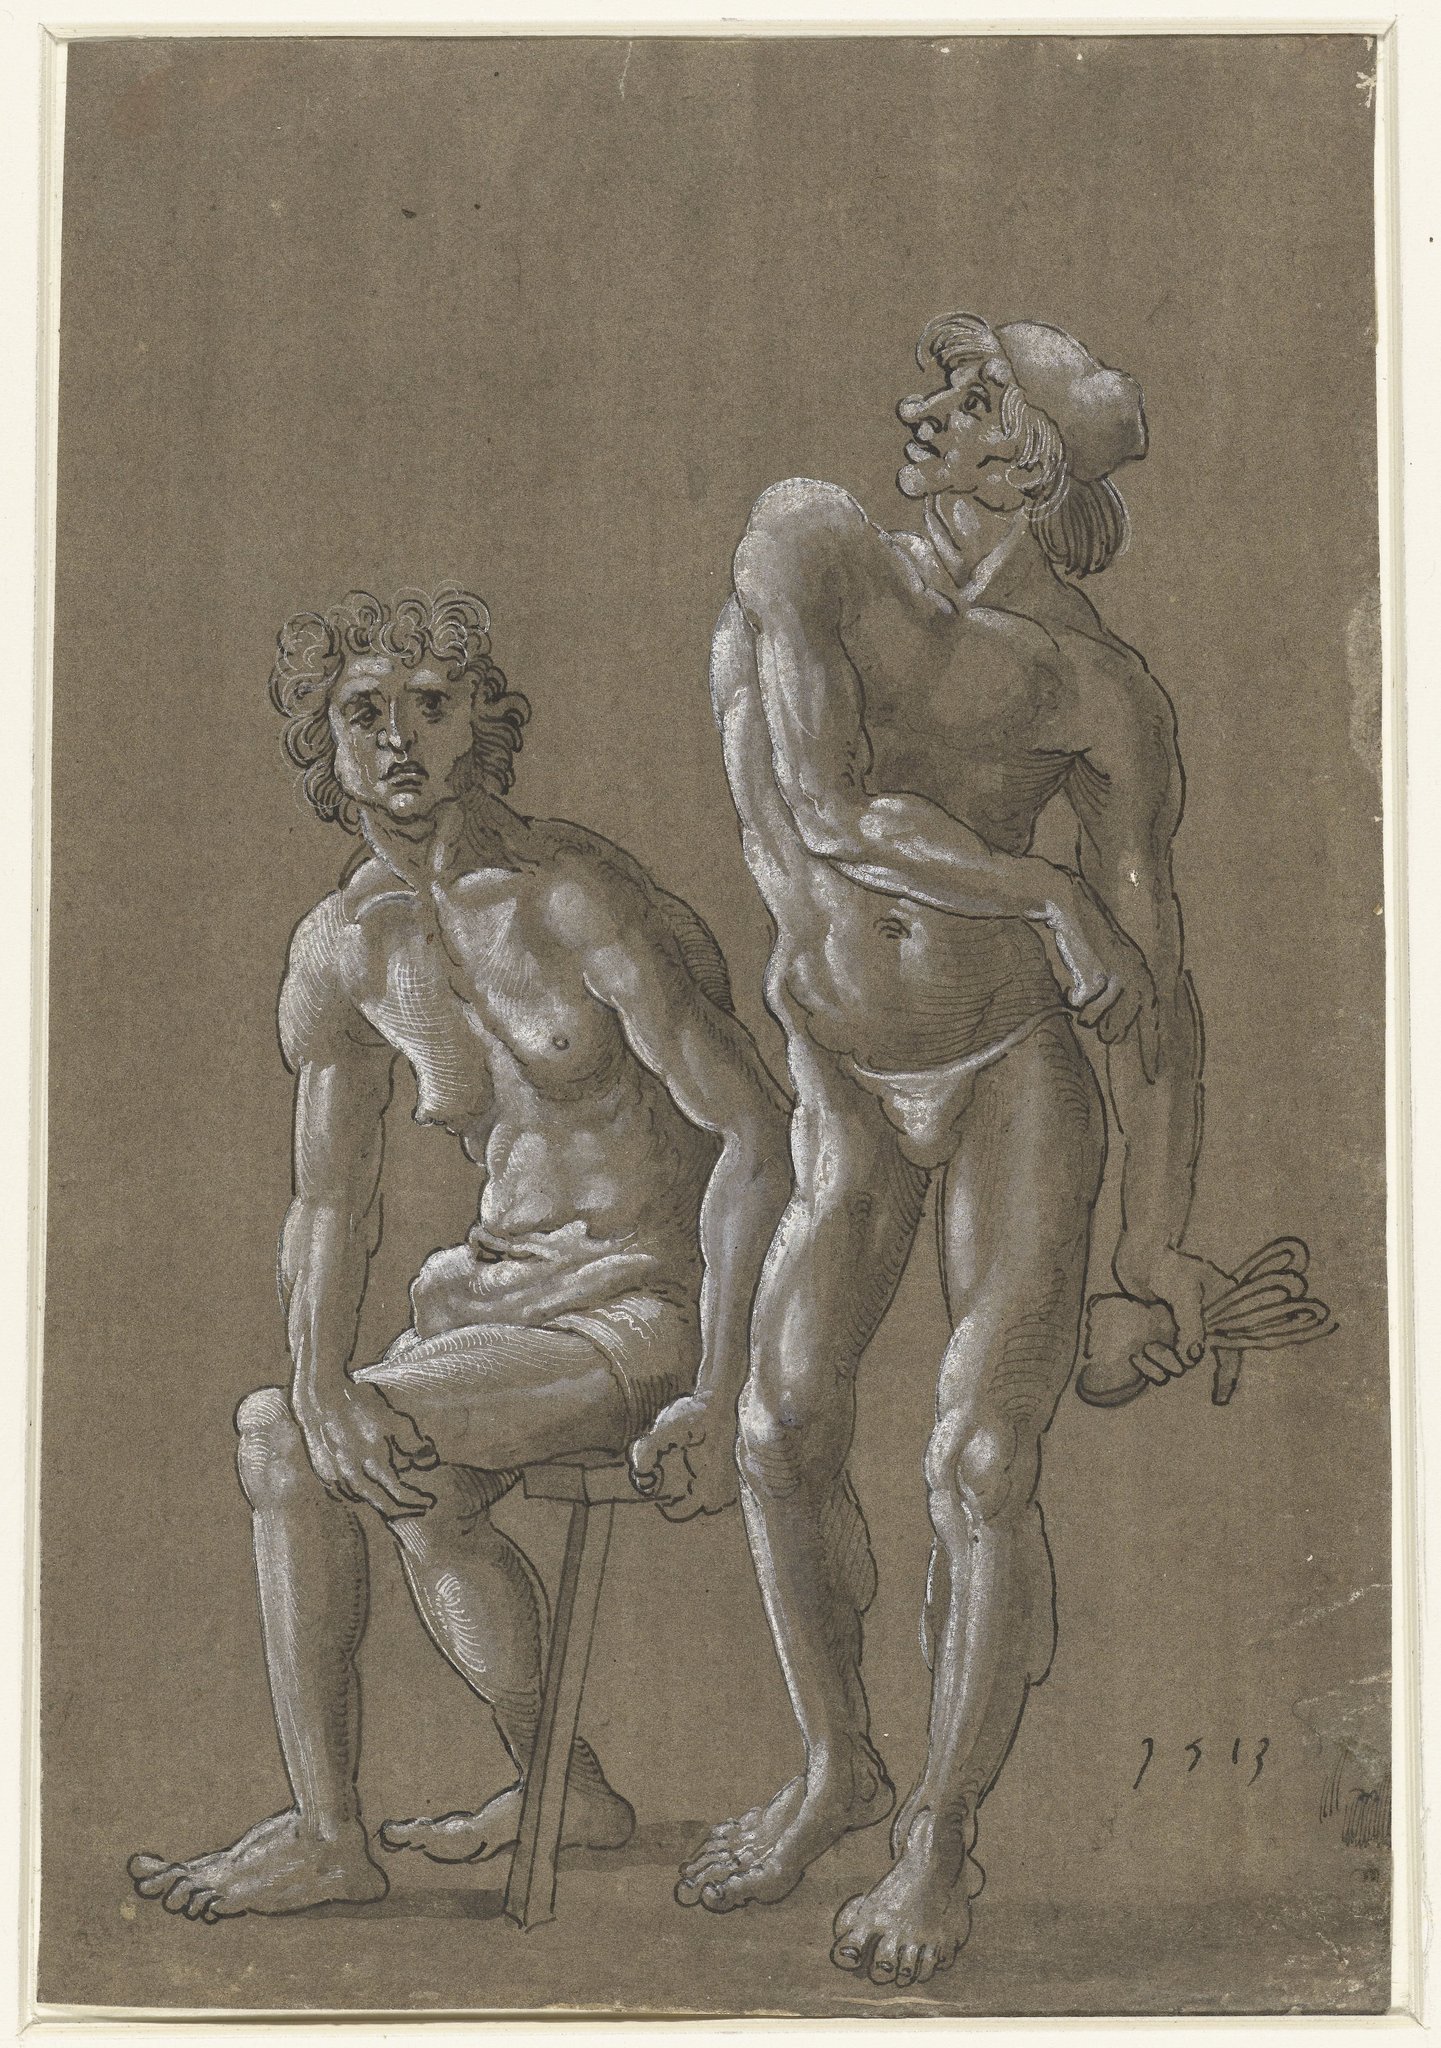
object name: drawing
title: Zittende en een staande naakte jongeling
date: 1513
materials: paint, ink, paper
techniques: brush, pen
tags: standing figure, sitting figure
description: Pendant van "Twee naakte jongelingen, naast elkaar staand" (inv. nr. RP-T-1951-9).